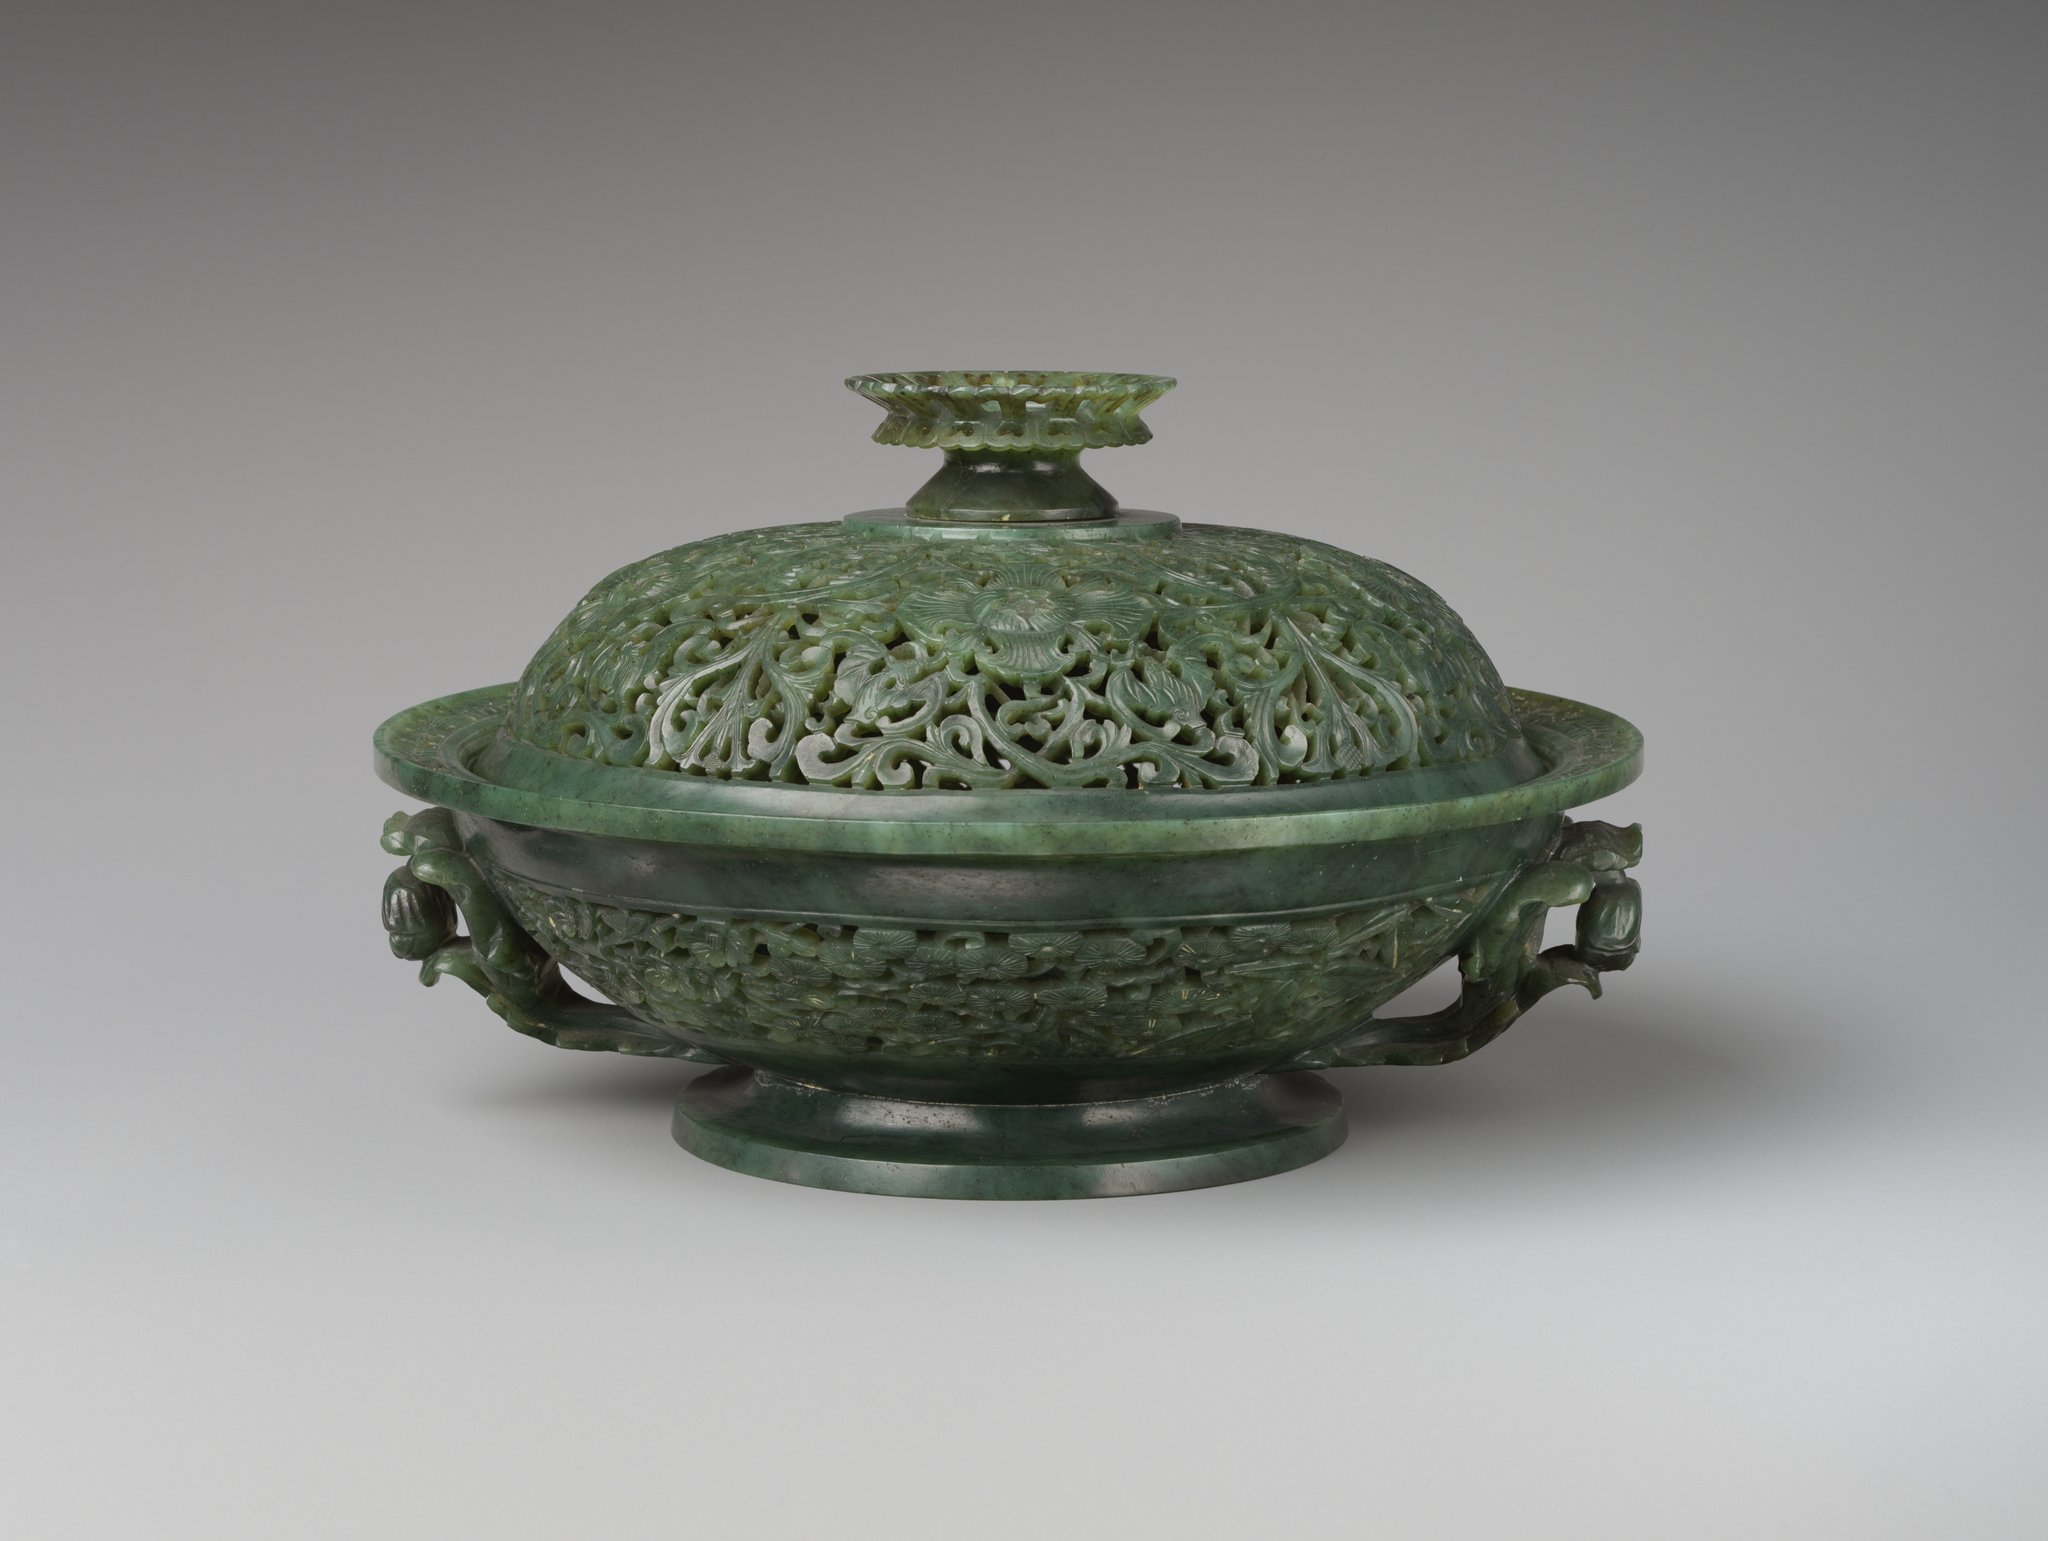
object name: bowl with cover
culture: chinese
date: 1796-1850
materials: jade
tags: flowers